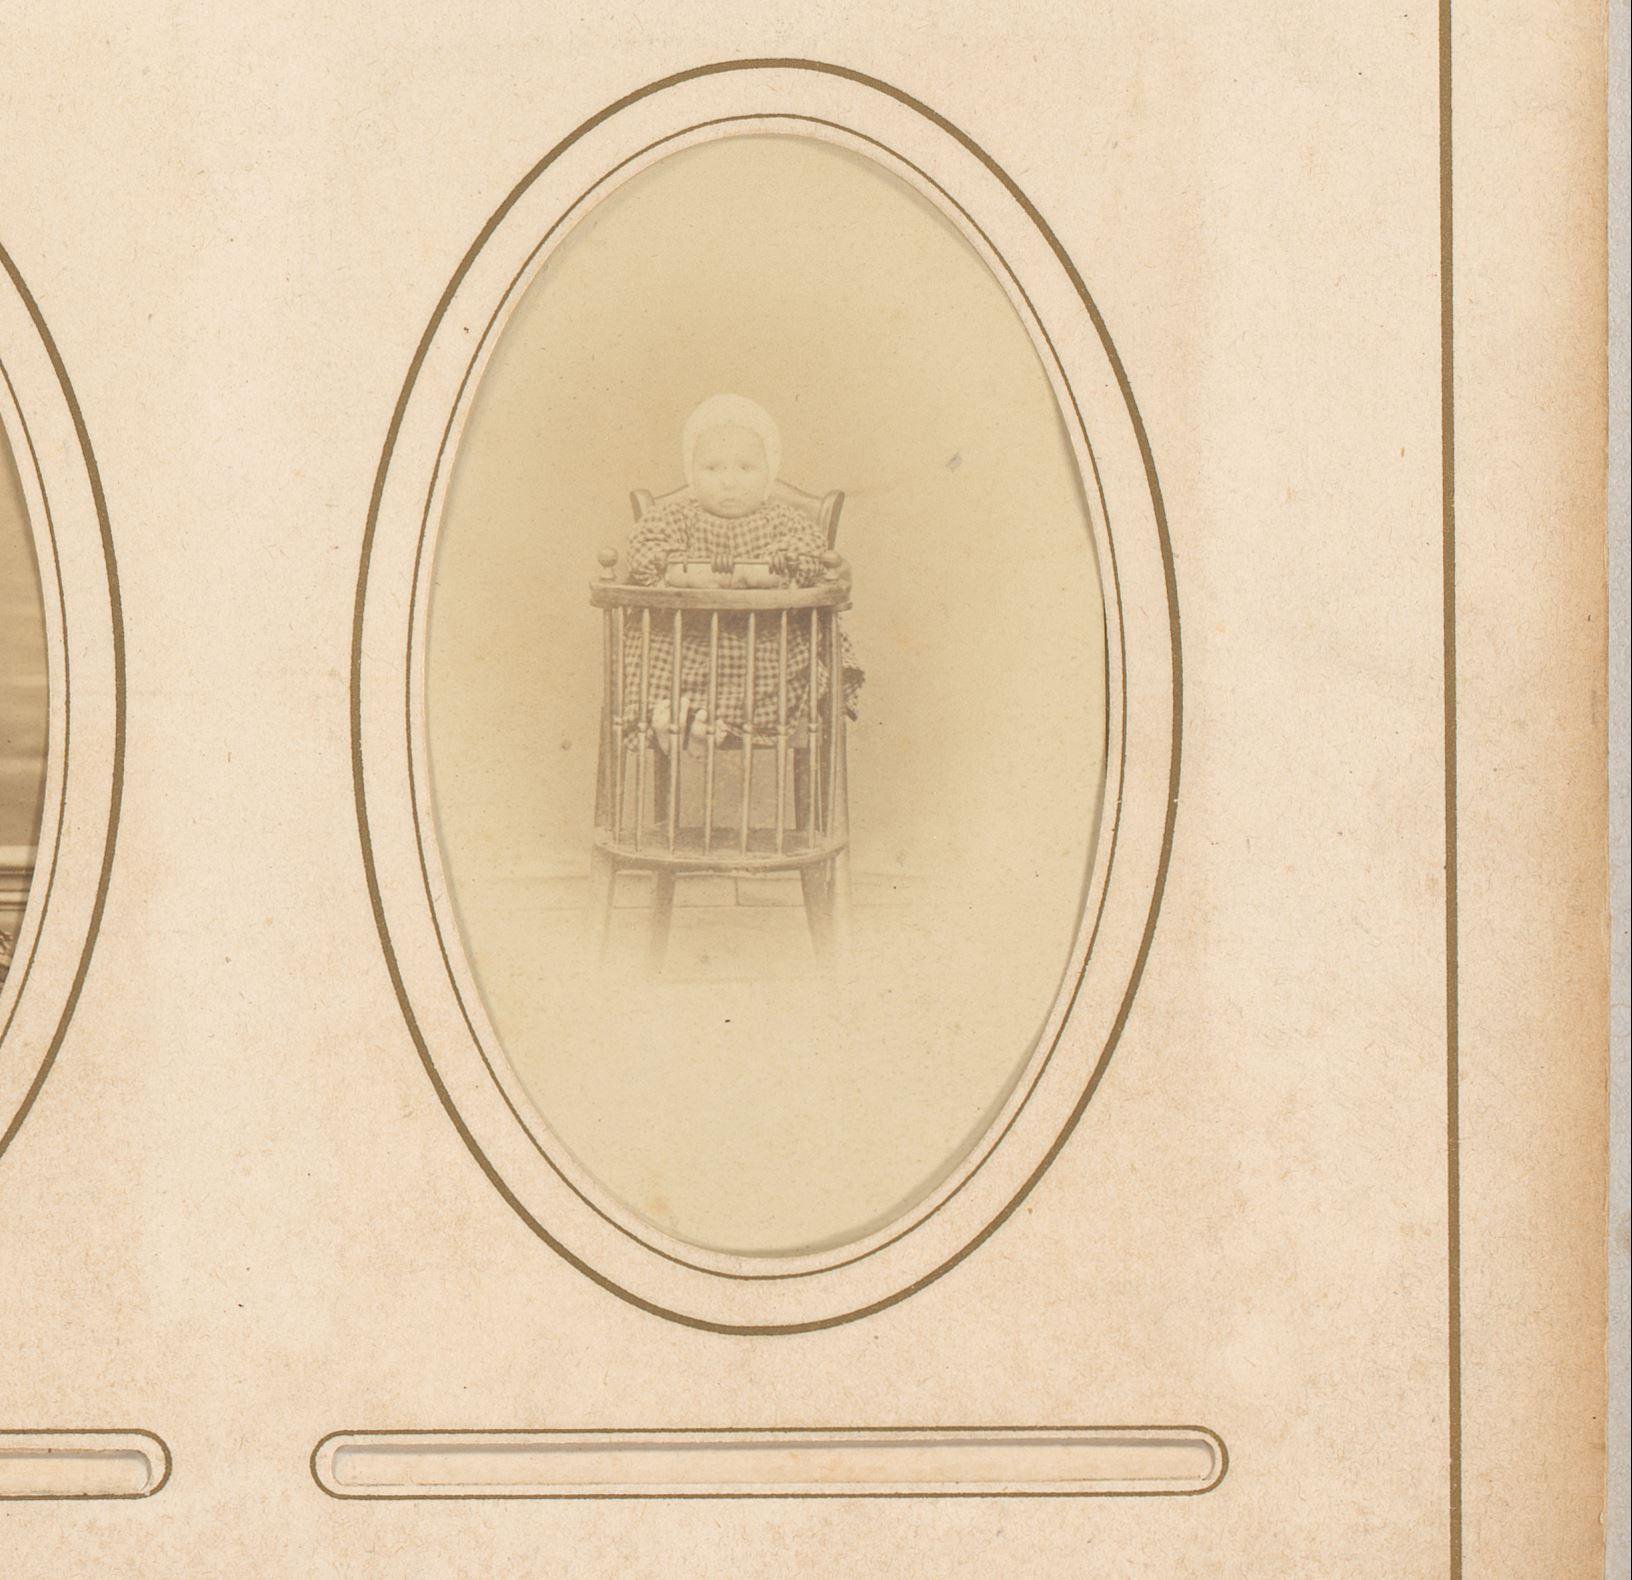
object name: album leaf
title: Portret van een kind in een kinderstoel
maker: Anonymous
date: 1860-1875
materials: cardboard, paper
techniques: albumen print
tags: baby-chair, historical persons, infant, baby